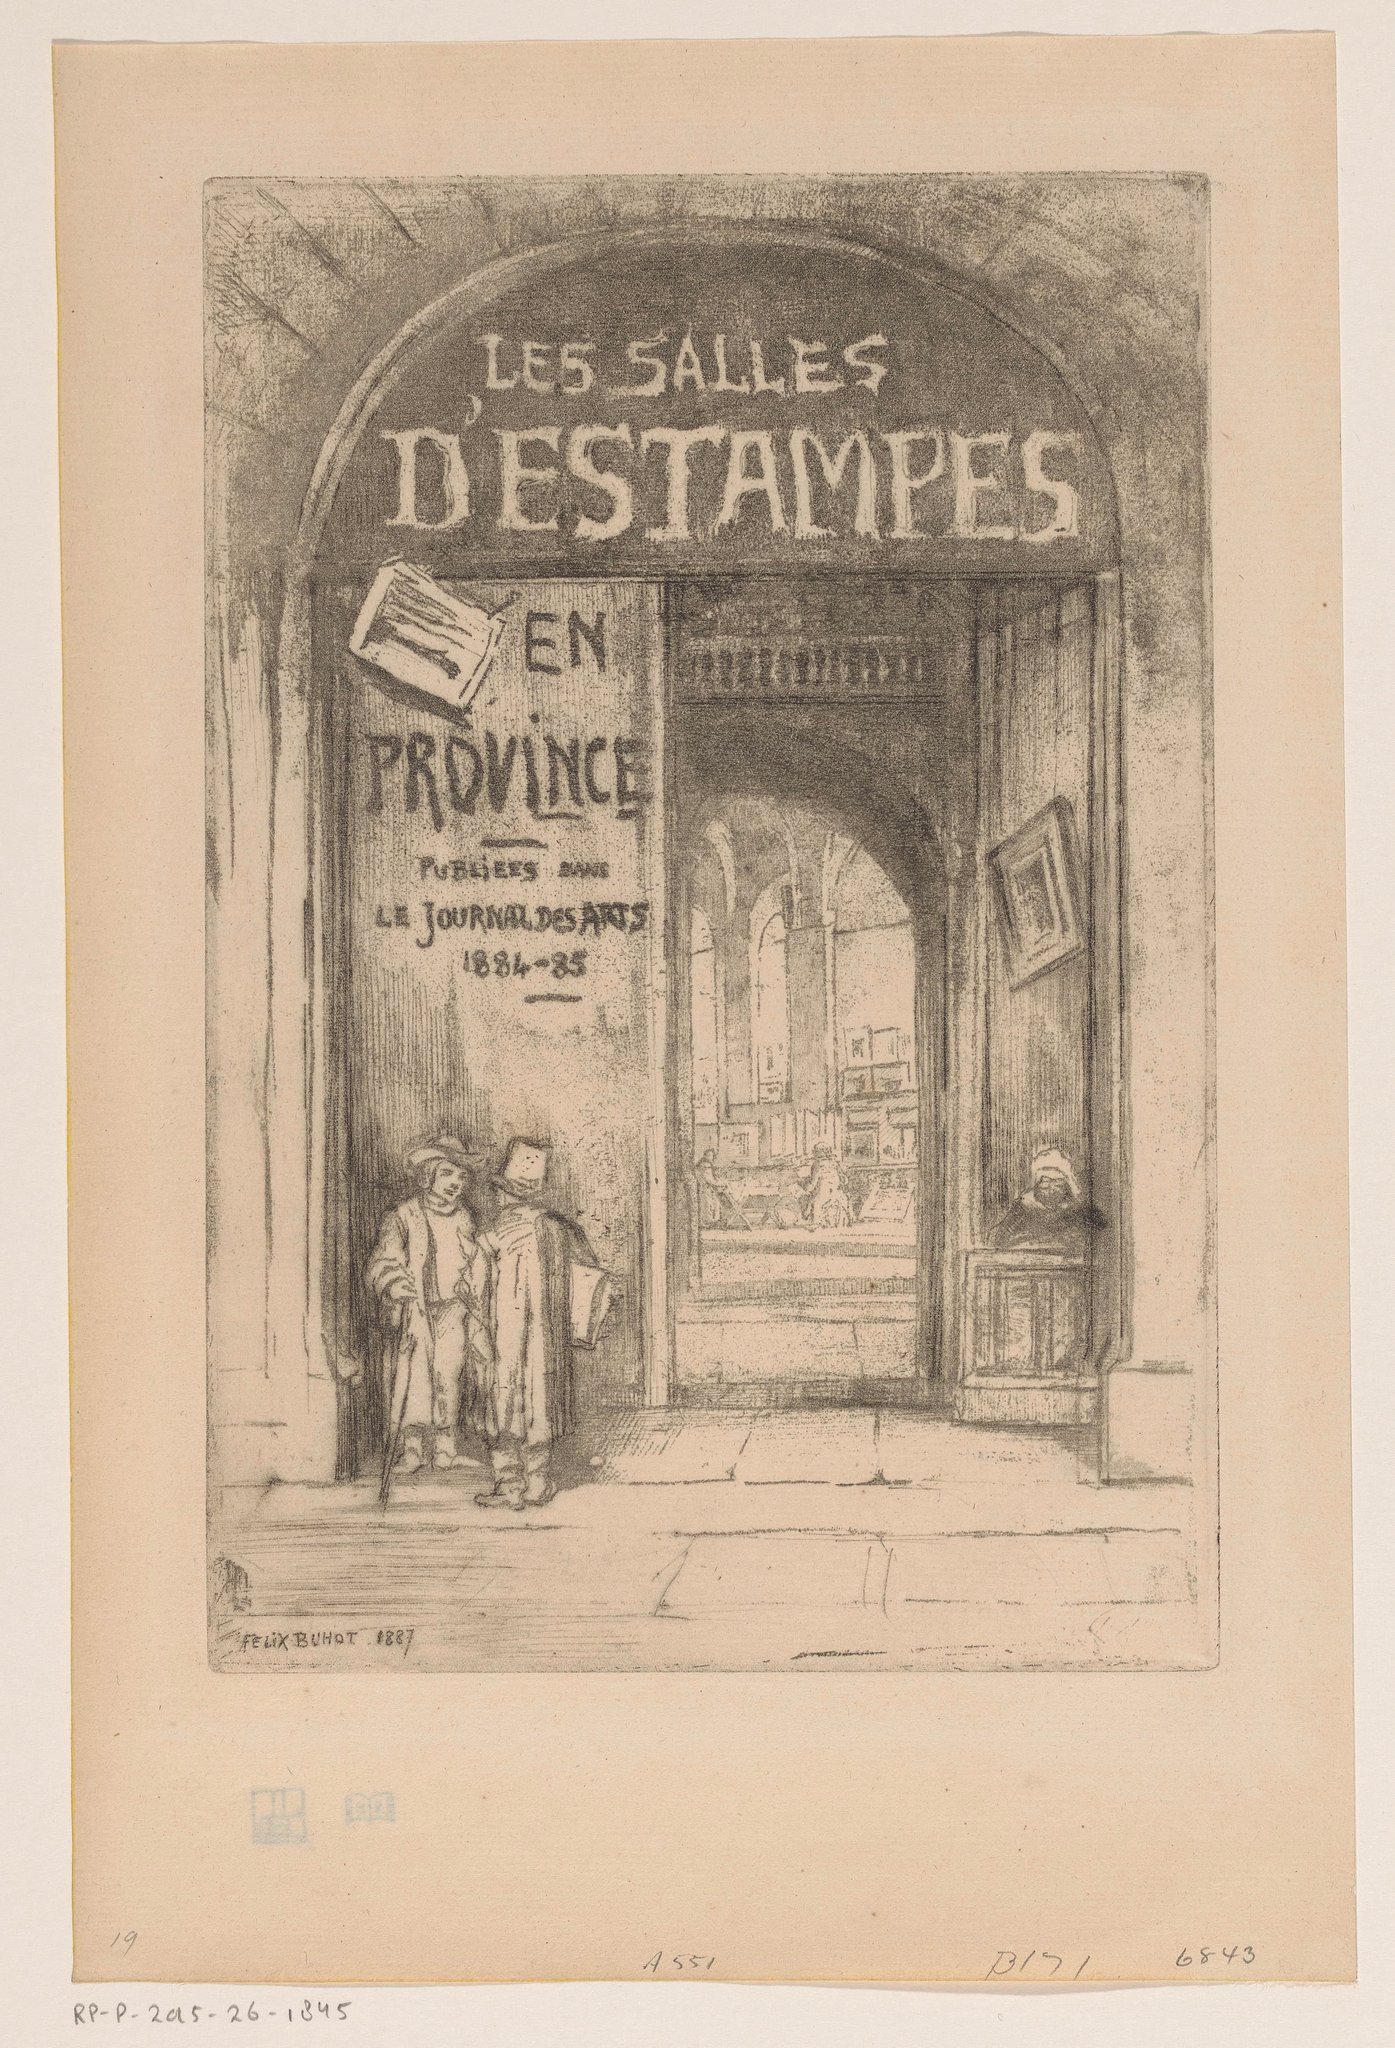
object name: print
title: Titelpagina voor: Les Salles d'estampes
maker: félix hilaire buhot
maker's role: draughtsman, print maker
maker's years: 1847-1898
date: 1887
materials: paper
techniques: drypoint, etching, soft ground etching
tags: art collector (+ graphic arts), permanent exhibition, museum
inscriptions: collector's mark: Lugt 4780, collector's mark: Lugt 2228, collector's mark: ‘JLP’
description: De prent is ontworpen als titelpagina voor de artikelen die in 1884-1885 verschenen onder de titel 'Les Salles d'estampes dans les musees de province' in het tijdschrift Journal des Arts.